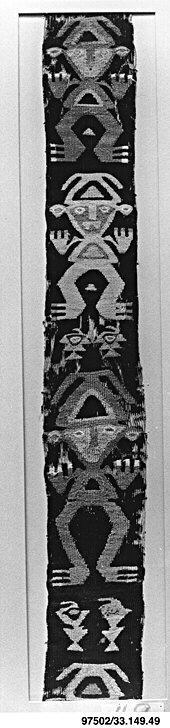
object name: border fragment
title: Tapestry Border Fragment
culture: peruvian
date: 901-1400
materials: animal fiber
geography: peru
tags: human figures